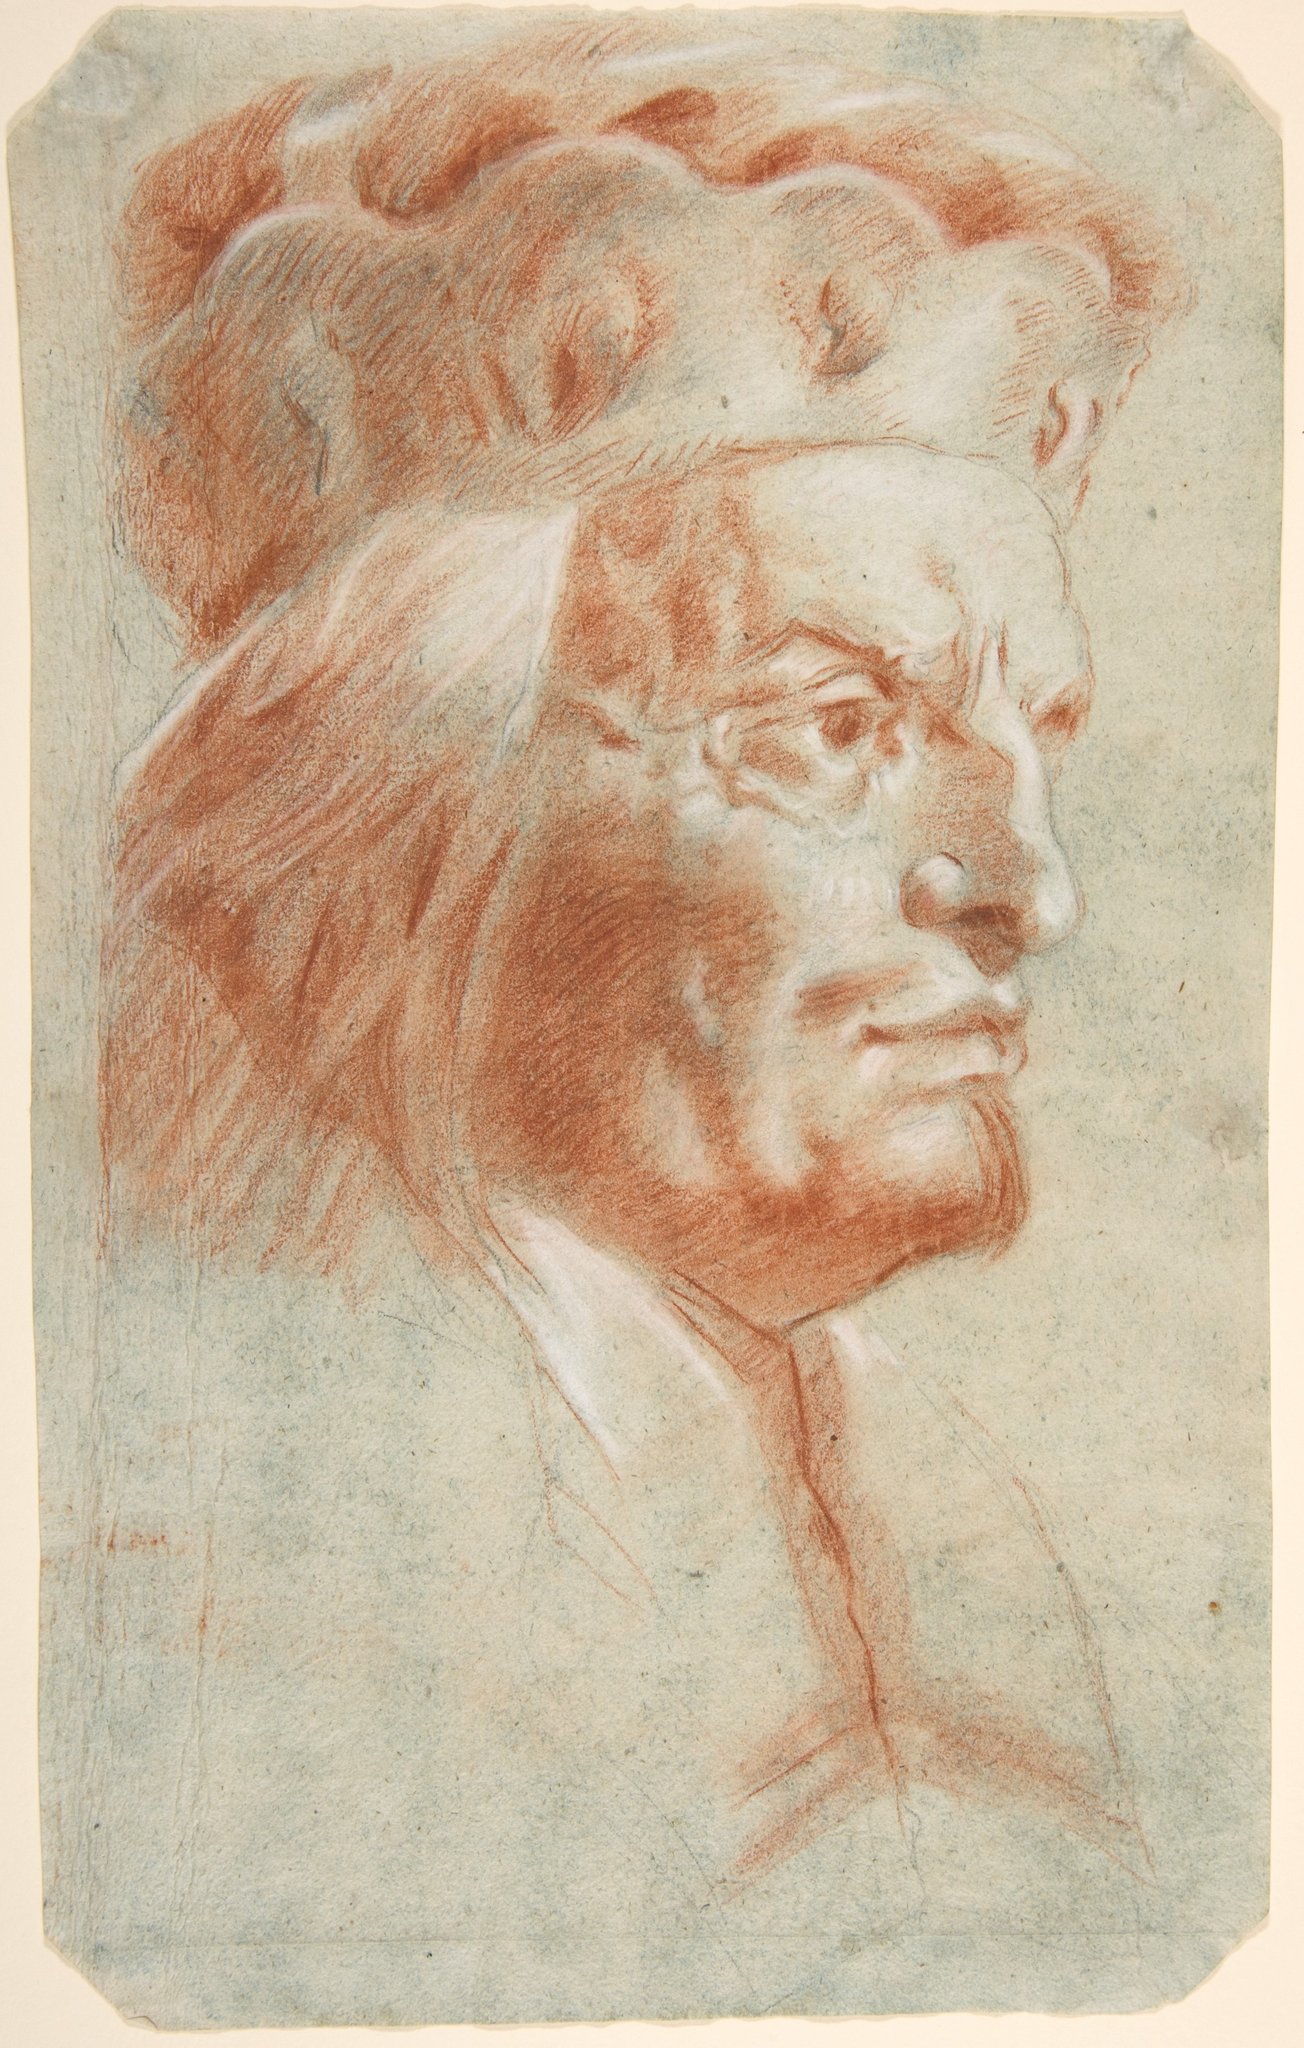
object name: drawing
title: Bust-Length Study of a Man Wearing a Hat in Three-Quarter View (a Frankish Nobleman)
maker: lorenzo tiepolo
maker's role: artist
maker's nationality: italian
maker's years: 1736-1776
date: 1701-1800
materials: chalk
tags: hats,men,profiles